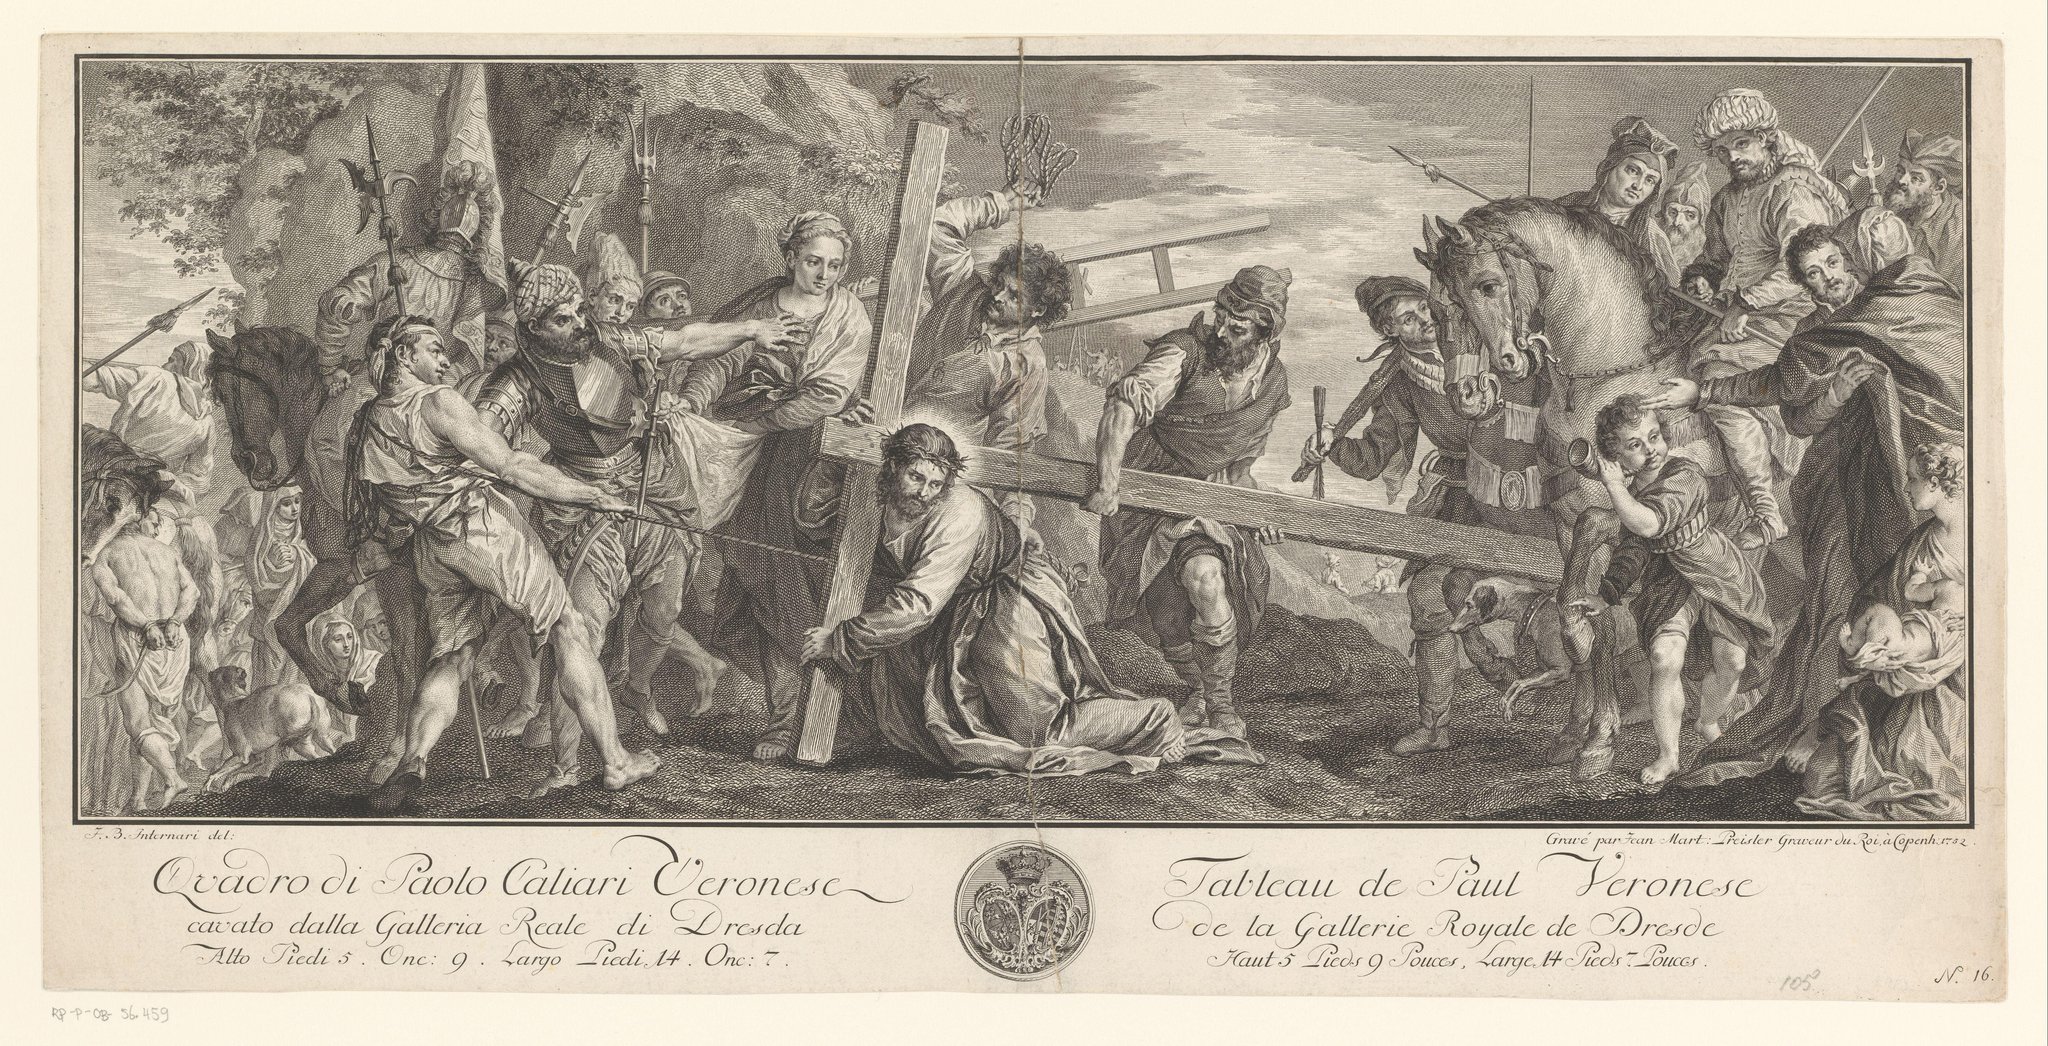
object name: print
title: Kruisdraging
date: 1752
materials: paper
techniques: etching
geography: copenhagen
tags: christ meets veronica, who has a cloth to wipe christ's face, carrying of the cross: christ bearing the cross, alone or with the help of others (e.g. simon the cyrenian)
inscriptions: collector's mark: Lugt 2228, collector's mark: Lugt 240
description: Tekst in het Frans in de ondermarge en rechtsonder nummer: 16. Rechts volgt Pilates te paard, centraal staat Veronica met zweetdoek en links lopen andere gevangenen.